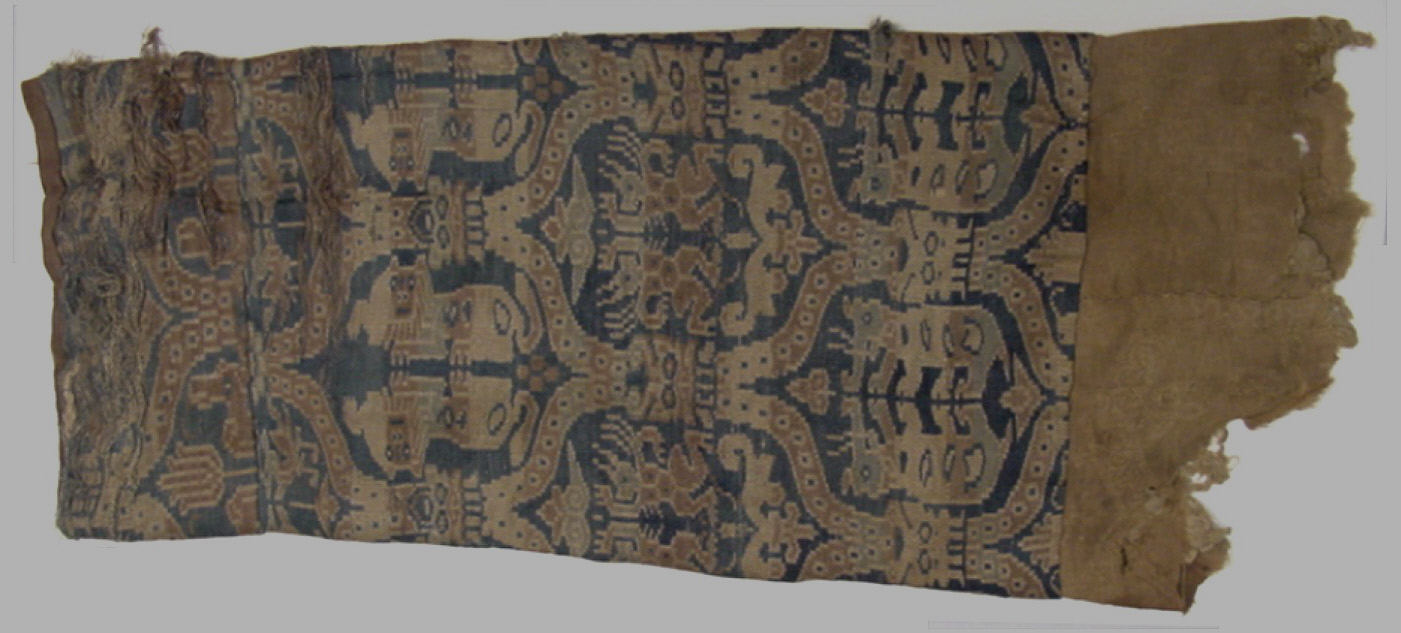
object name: sleeve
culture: chinese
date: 401-600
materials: silk